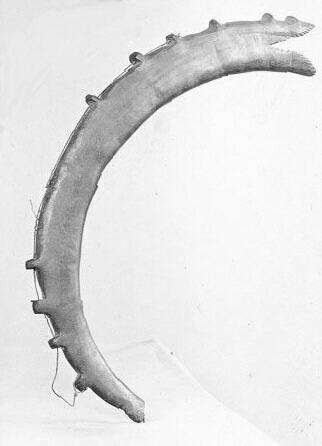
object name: horn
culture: african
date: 1867-1900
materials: wood